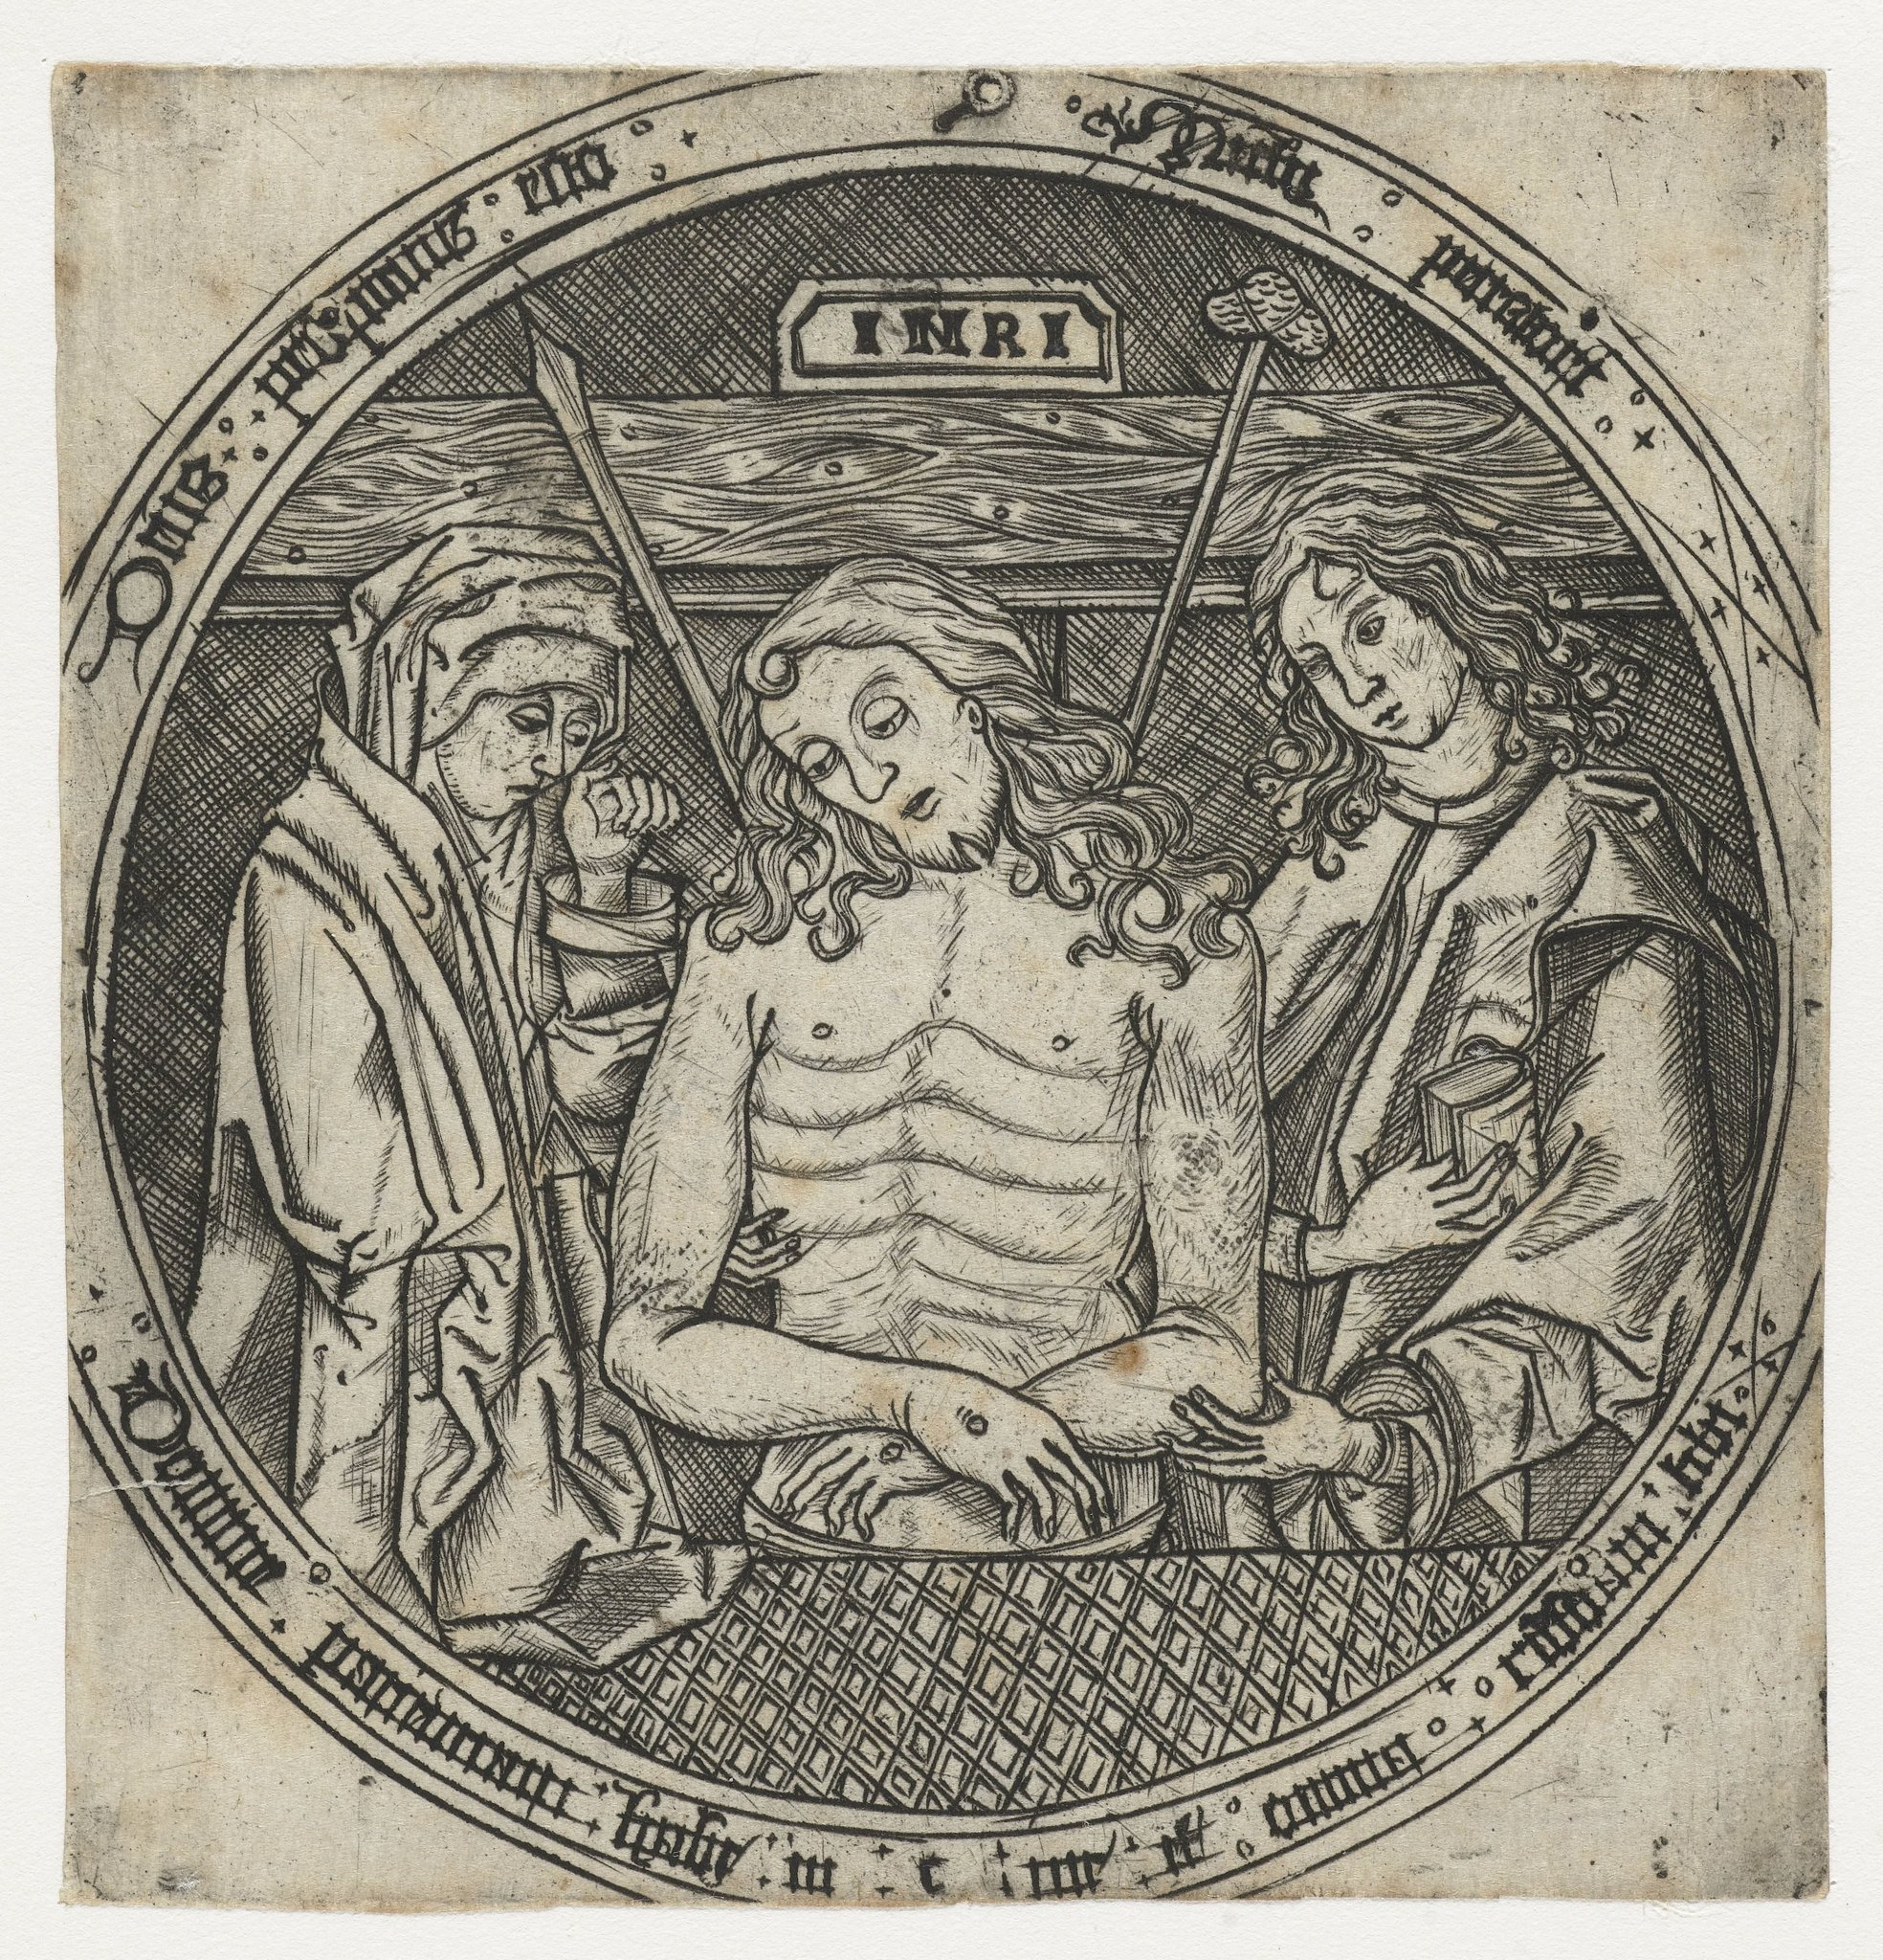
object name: print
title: Man van Smarten tussen Maria en Johannes de Evangelist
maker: Anonymous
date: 1455-1503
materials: paper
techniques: engraving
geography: low countries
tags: man of sorrows, 'imago pietatis', 'erbärmdebild', 'schmerzensmann'; the upright christ showing his wounds, usually bearing the crown of thorns, and accompanied by the instruments of the passion, standing or sitting in his tomb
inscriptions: collector's mark: Lugt 240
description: Ronde voorstelling van Christus voor het kruis, ondersteund door Maria en Johannes de Evangelist. Latijns randschrift in gotisch schrift.